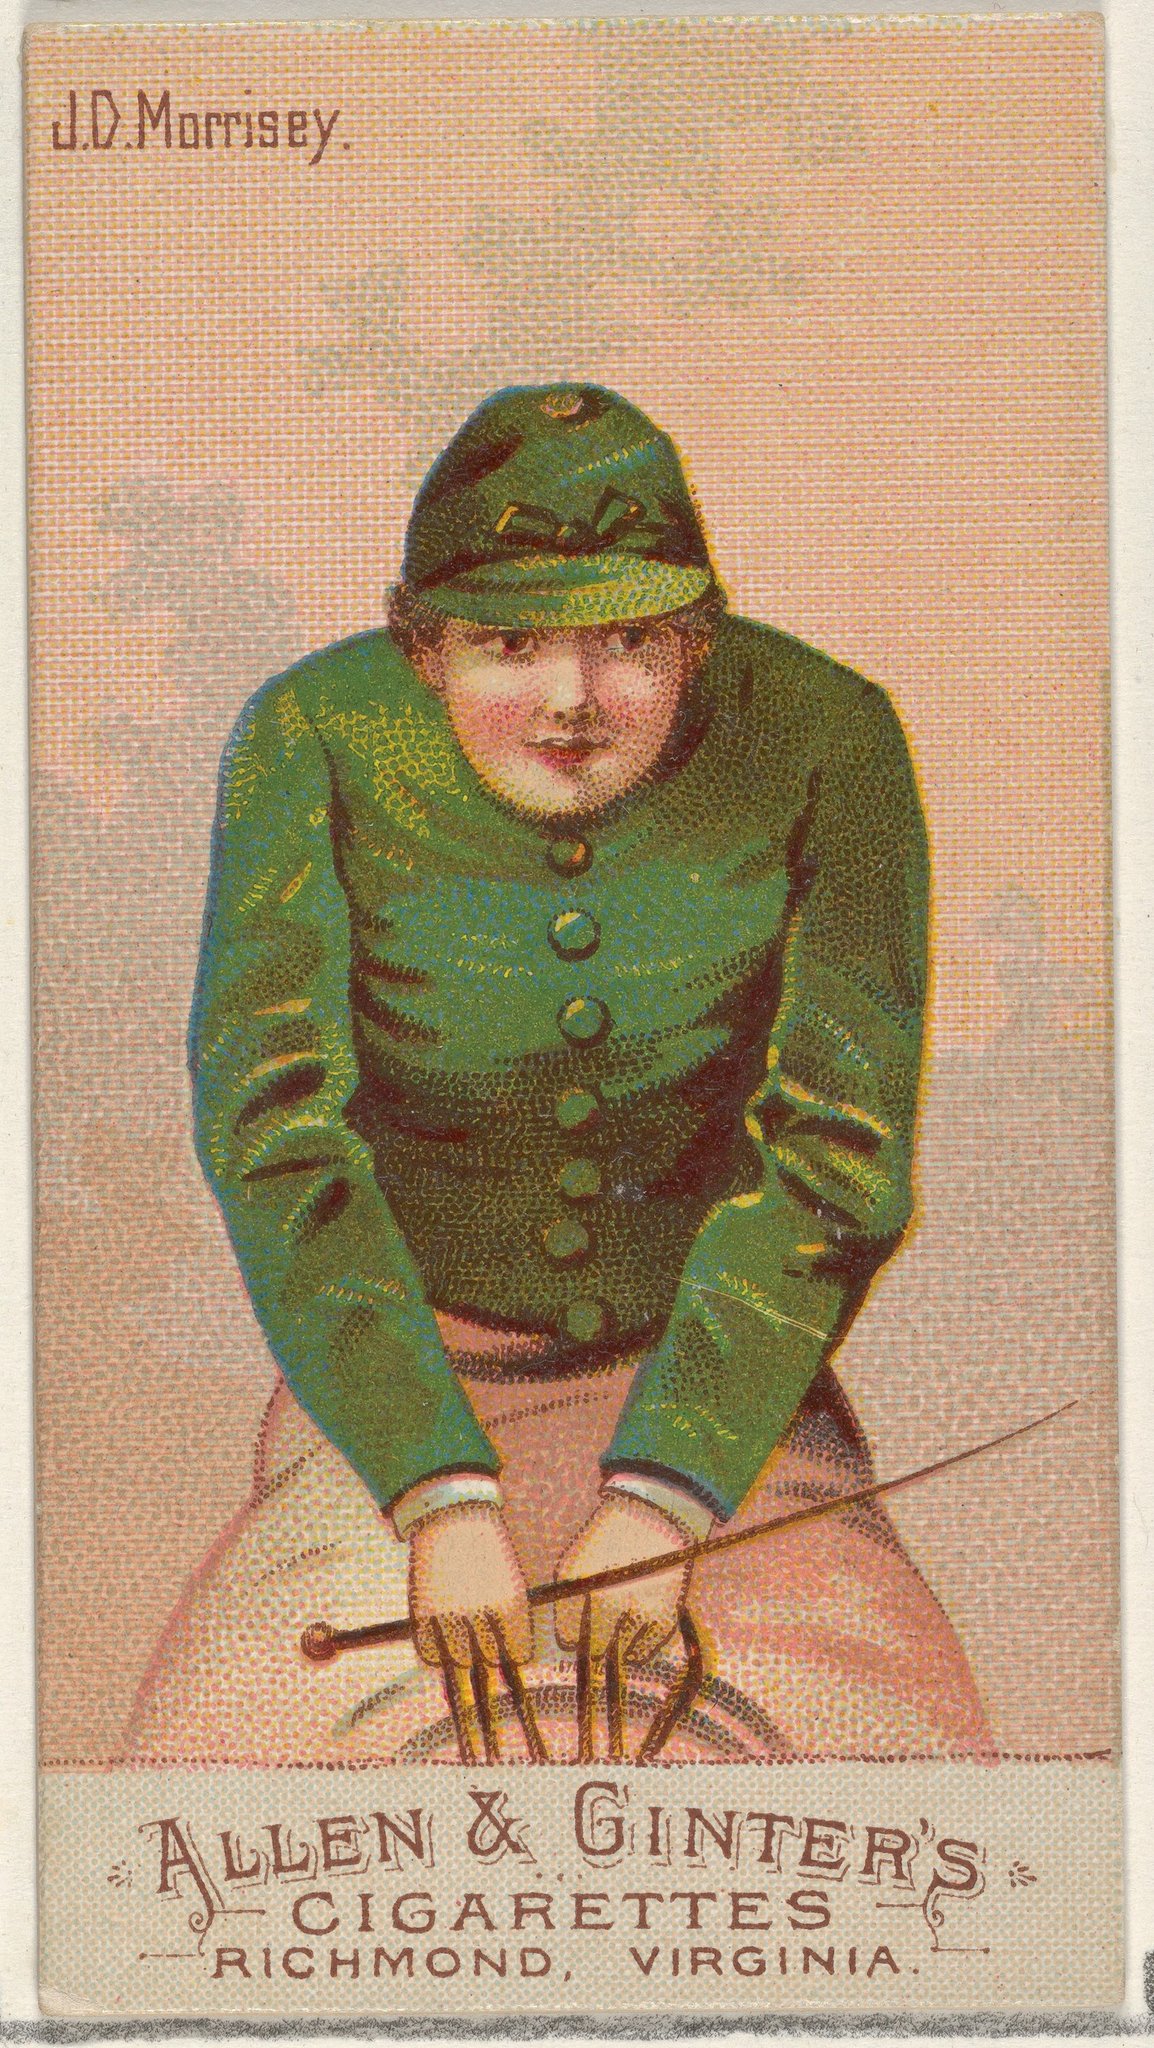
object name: print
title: J.D. Morrisey, from the Racing Colors of the World series (N22b) for Allen & Ginter Cigarettes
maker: allen & ginter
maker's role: publisher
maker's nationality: american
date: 1888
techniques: color lithograph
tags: women,jockeys